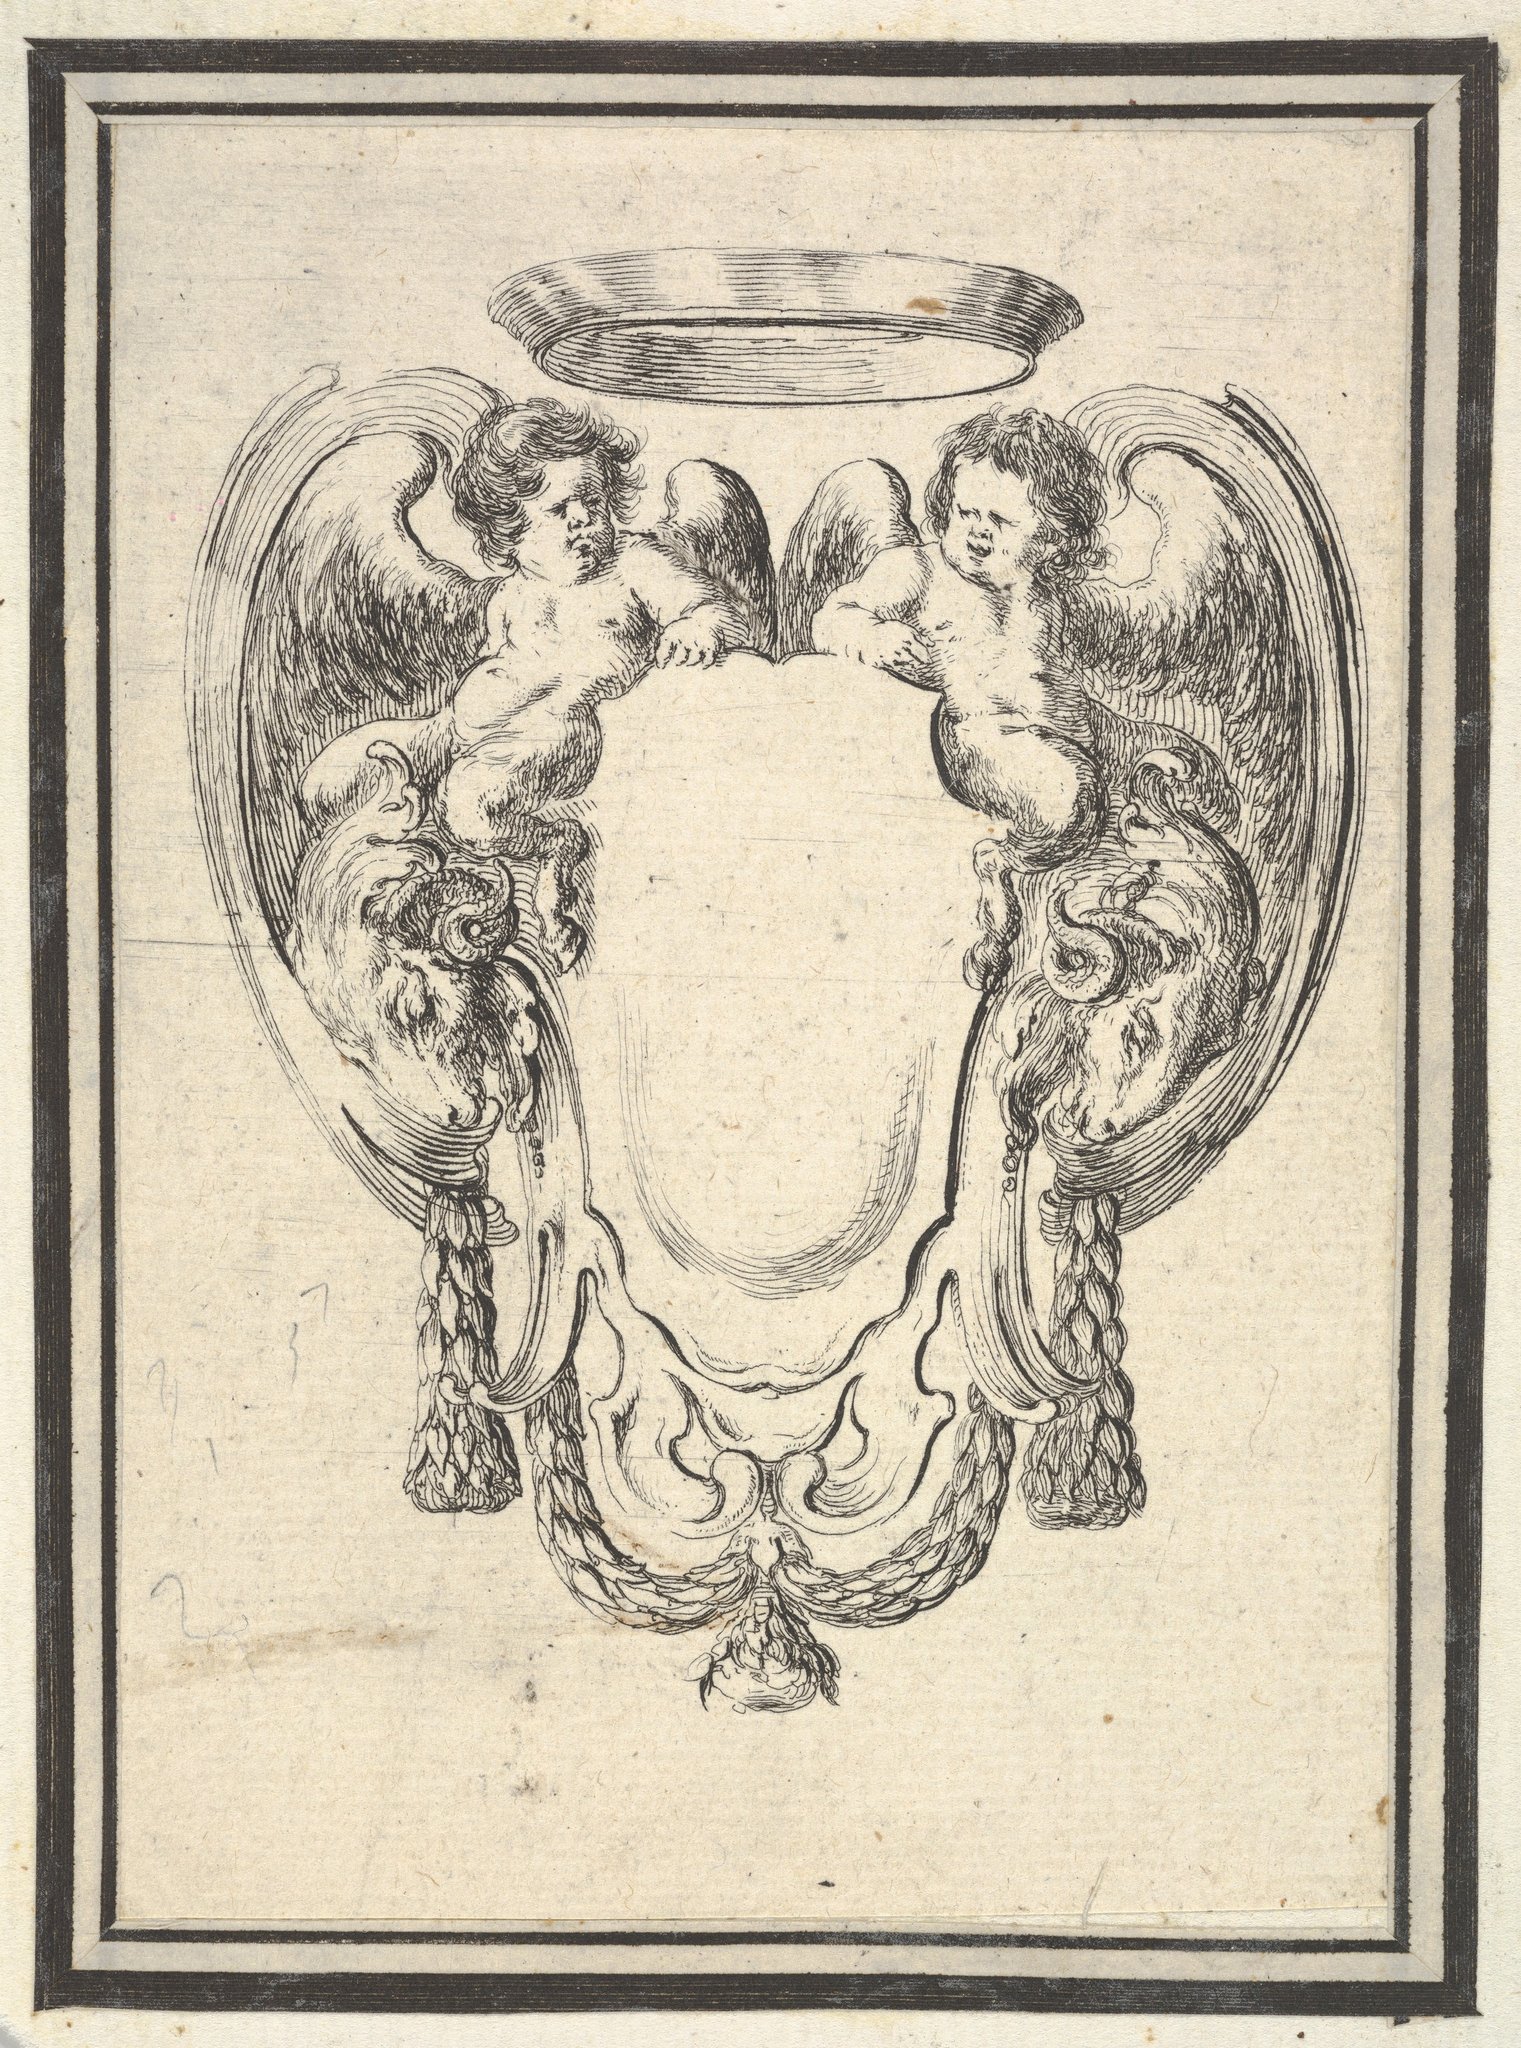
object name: print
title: A cartouche flanked by two winged infant satyrs riding on the heads of two rams, plate 12 from "Nouvelles inventions de Cartouches"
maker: stefano della bella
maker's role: artist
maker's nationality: italian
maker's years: 1610-1664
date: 1647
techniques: etching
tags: cartouches,satyrs,rams